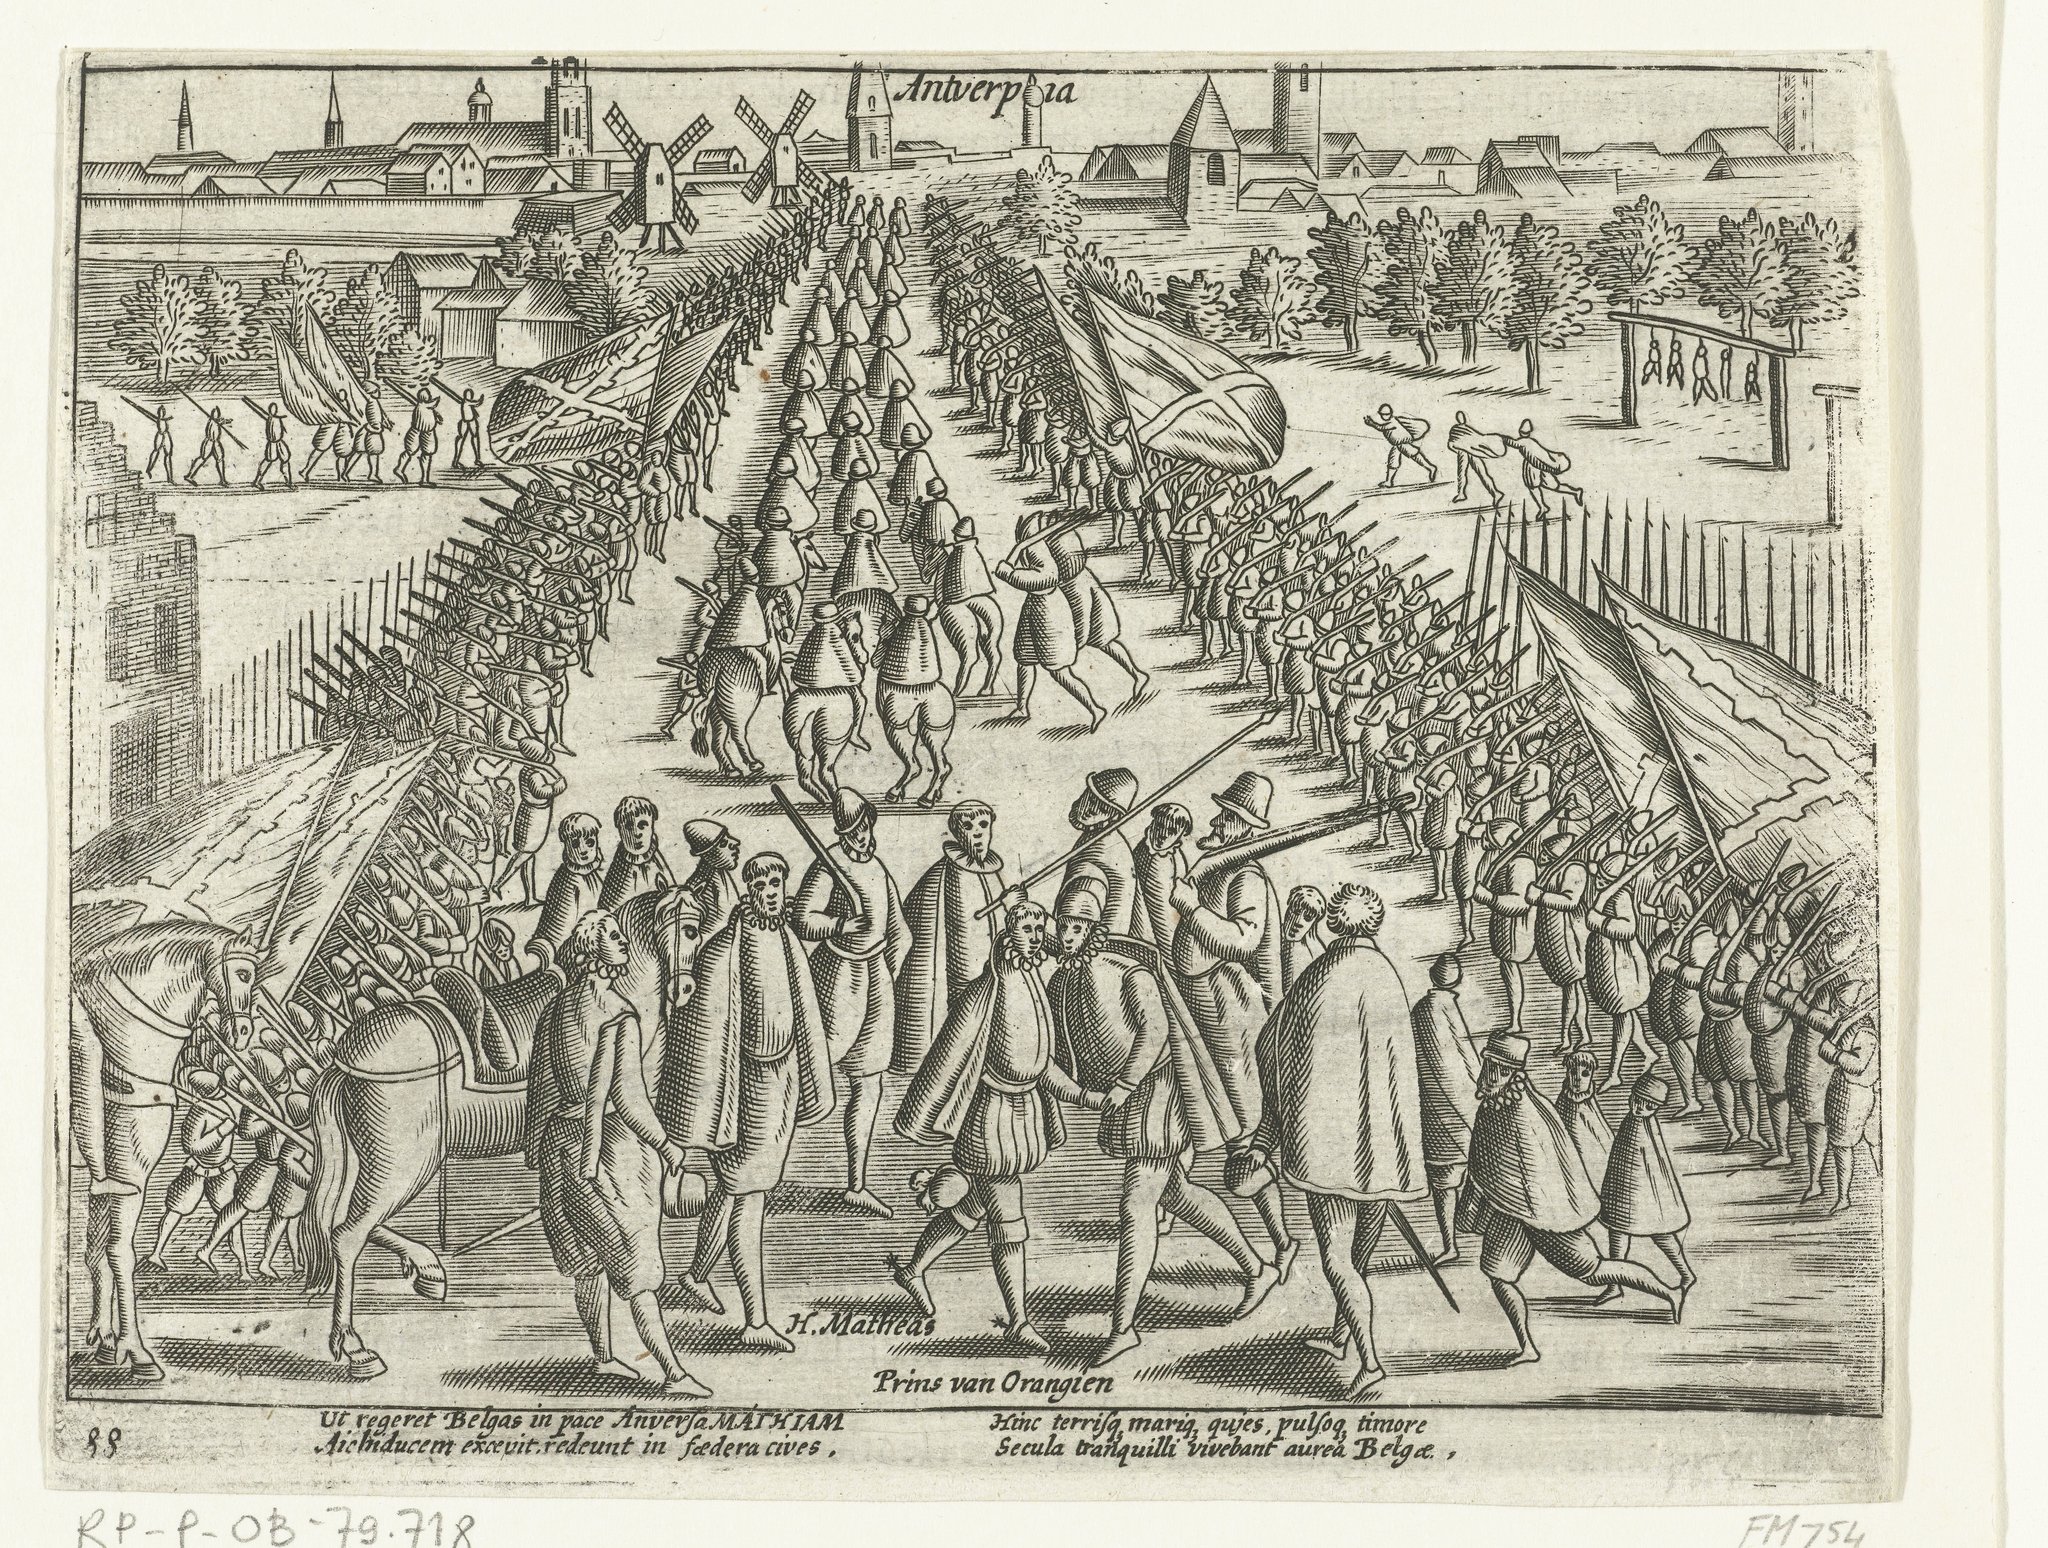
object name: print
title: Intocht van aartshertog Matthias te Antwerpen, 1577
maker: Anonymous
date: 1613-1615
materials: paper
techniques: engraving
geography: northern netherlands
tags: matthias van oostenrijk (rooms-duits keizer), william i (prince of orange), triumphal entry and public reception, pageant, 'entrée solennelle', 'joyeuse entrée', antwerp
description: Aankomst van aartshertog Matthias van Oostenrijk te Antwerpen, 21 november 1577. Matthias wordt verwelkomd door de prins van Oranje. De stoet trekt tussen hagen van soldaten langs het galgenveld naar de stad. Met onderschrift van 4 regels in het Latijn. Genummerd: 88. Bedrukt op achterzijde met tekst in het Latijn.